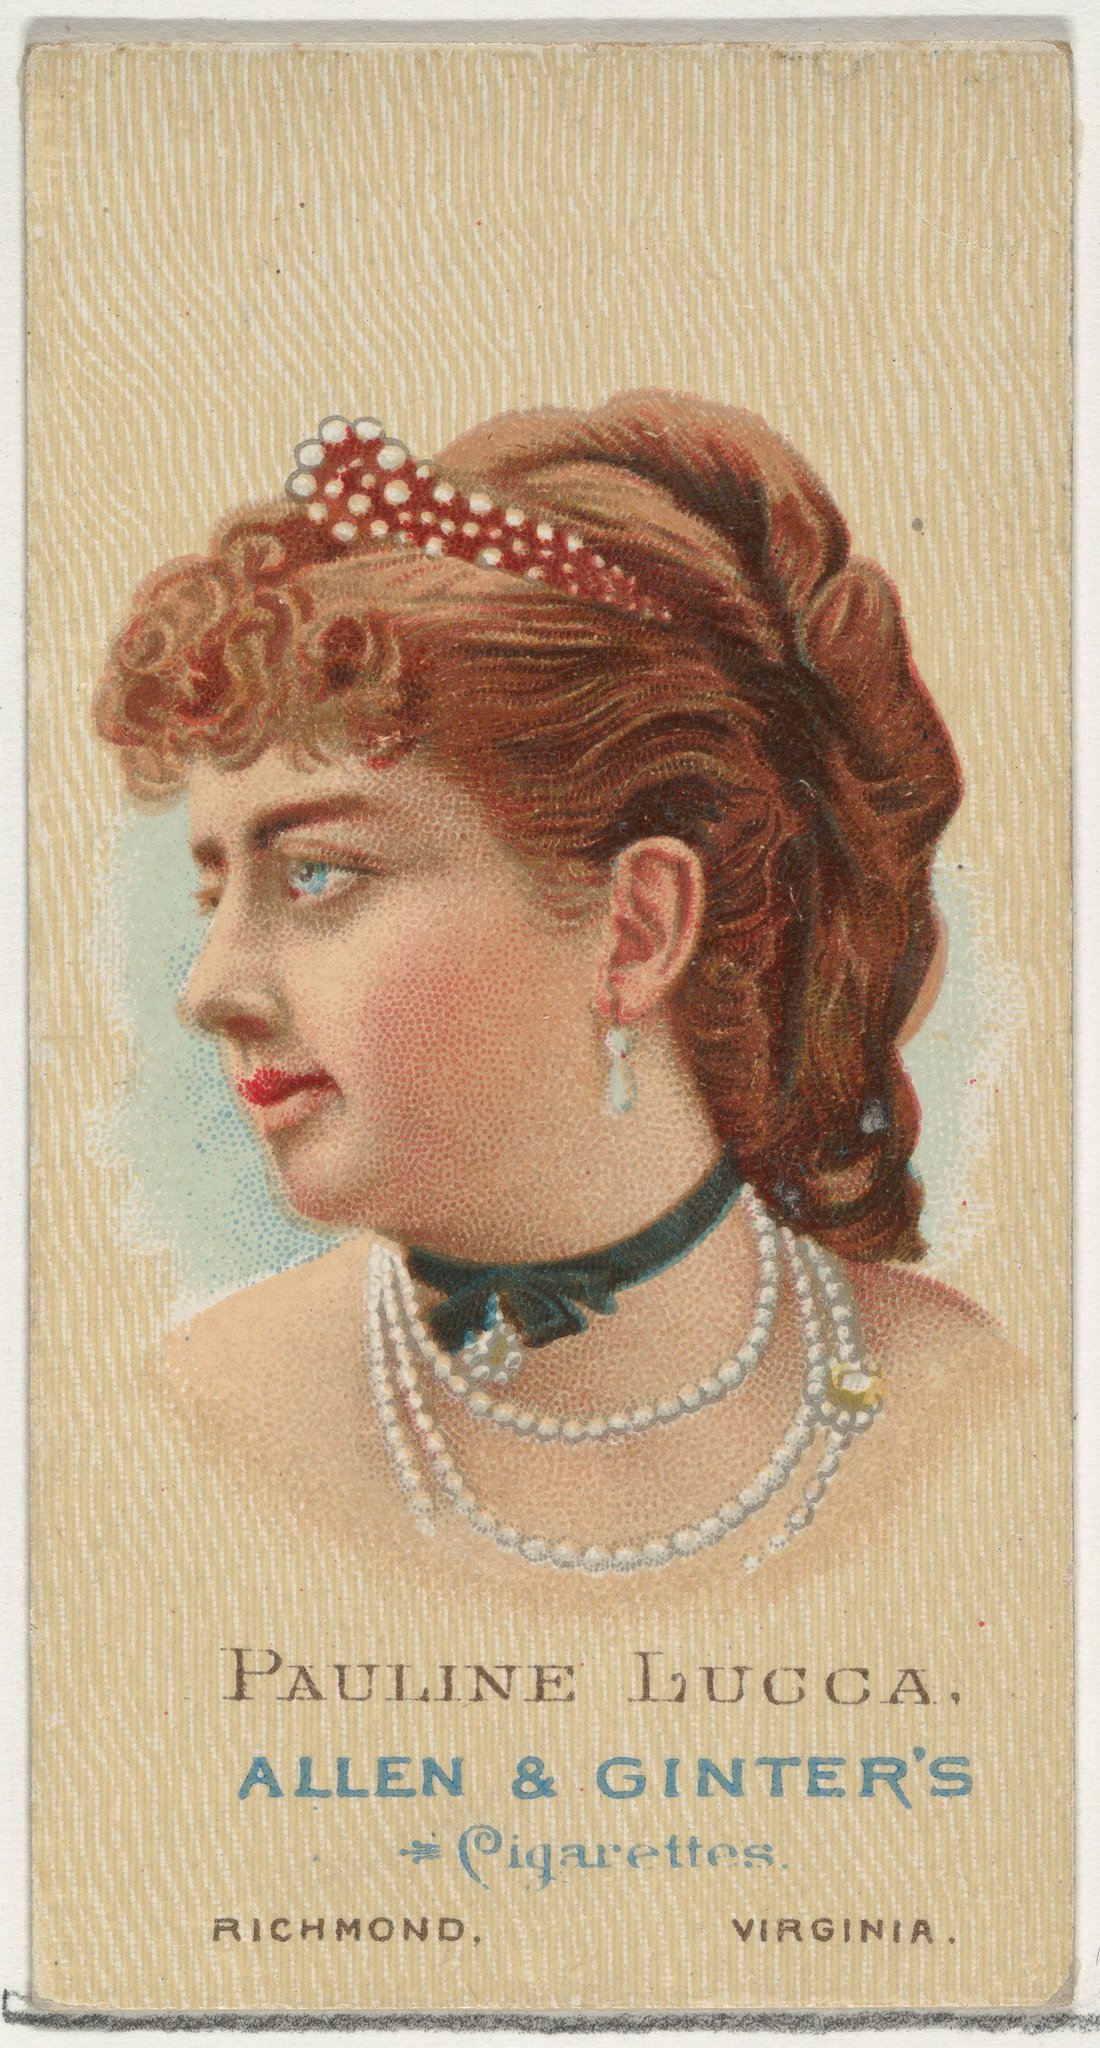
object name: print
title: Pauline Lucca, from World's Beauties, Series 2 (N27) for Allen & Ginter Cigarettes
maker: allen & ginter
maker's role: publisher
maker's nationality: american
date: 1888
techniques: color lithograph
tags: women